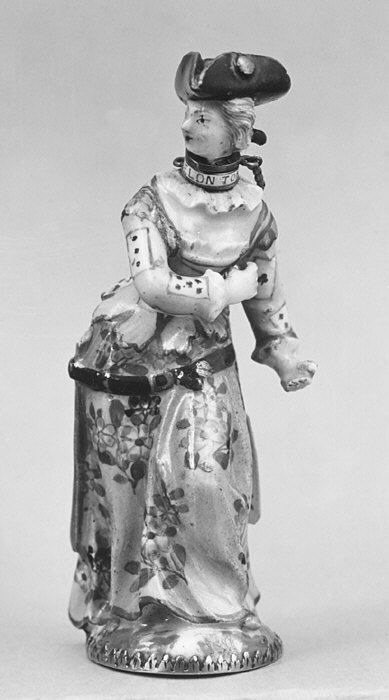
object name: scent bottle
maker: meissen manufactory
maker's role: manufactory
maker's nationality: german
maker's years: 1710-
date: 1760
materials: metal, porcelain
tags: women,flowers